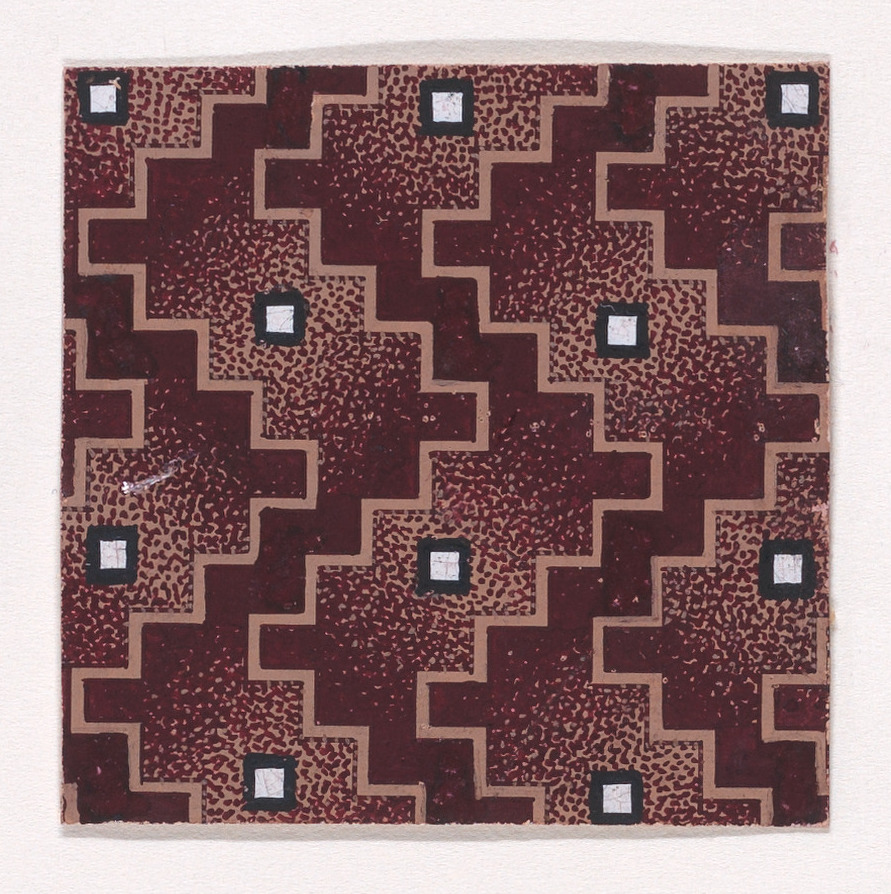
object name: drawing ornament architecture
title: Textile Design with Alternating Vertical Rows of Pearls Framed by Undulating Vertical Zig-Zagging Lines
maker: anonymous, alsatian, 19th century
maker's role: artist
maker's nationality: alsatian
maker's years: 1800-1900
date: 1840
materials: gouache